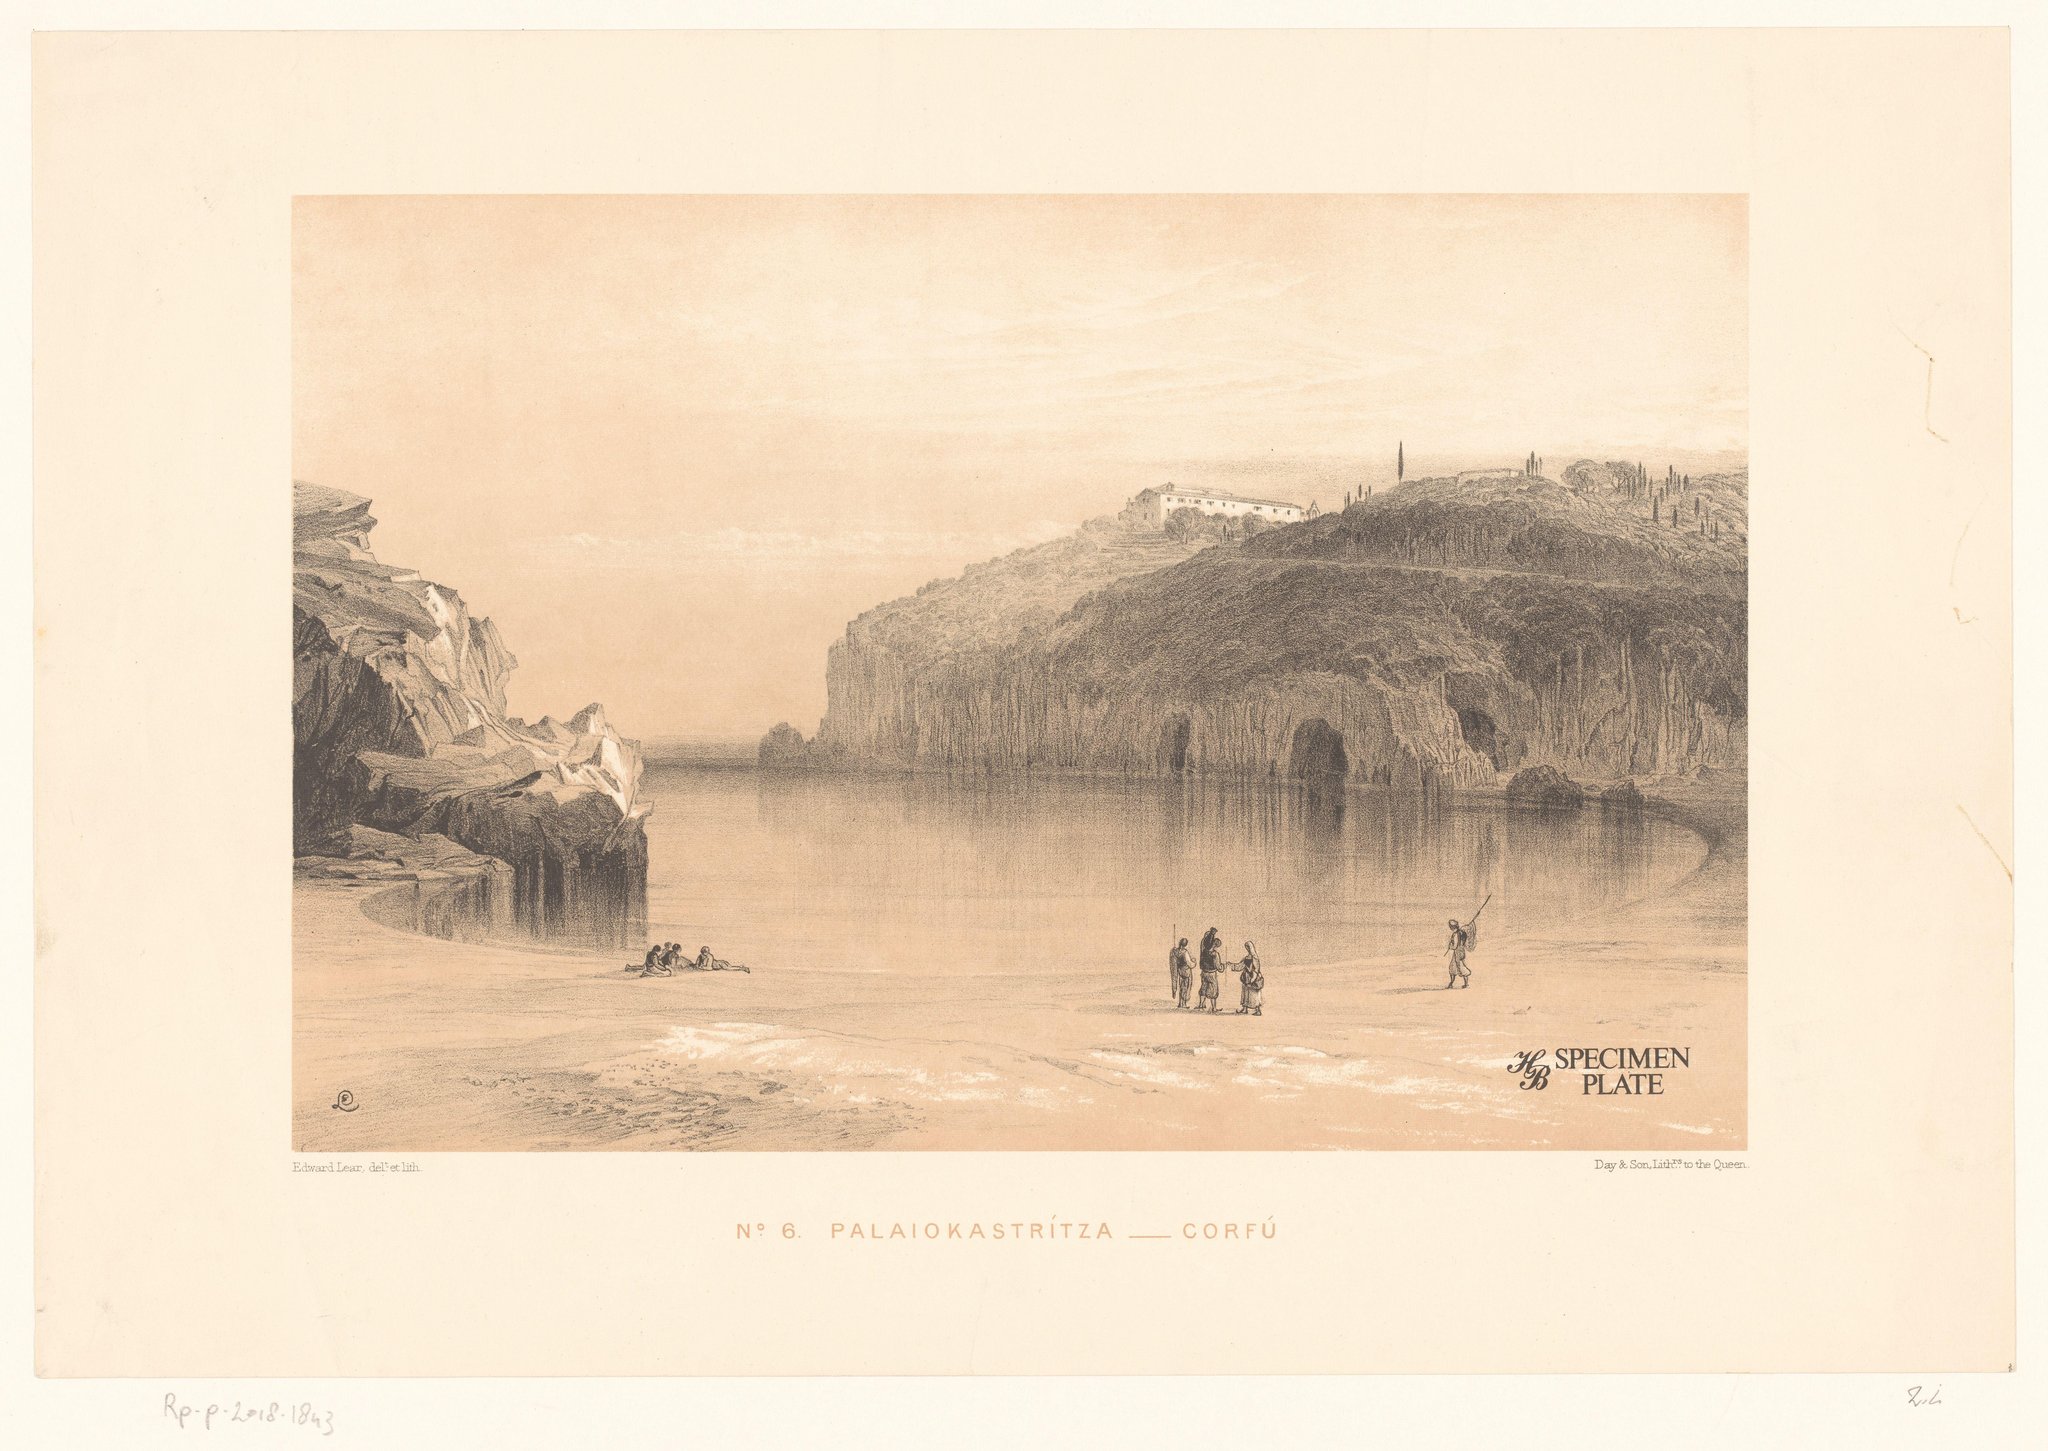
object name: print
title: Palaiokastritza - Corfú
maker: edward lear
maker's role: draughtsman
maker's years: 1812-1888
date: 1824-1888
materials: paper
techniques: lithograph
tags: gulf, bay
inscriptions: collector's mark: Lugt 2228